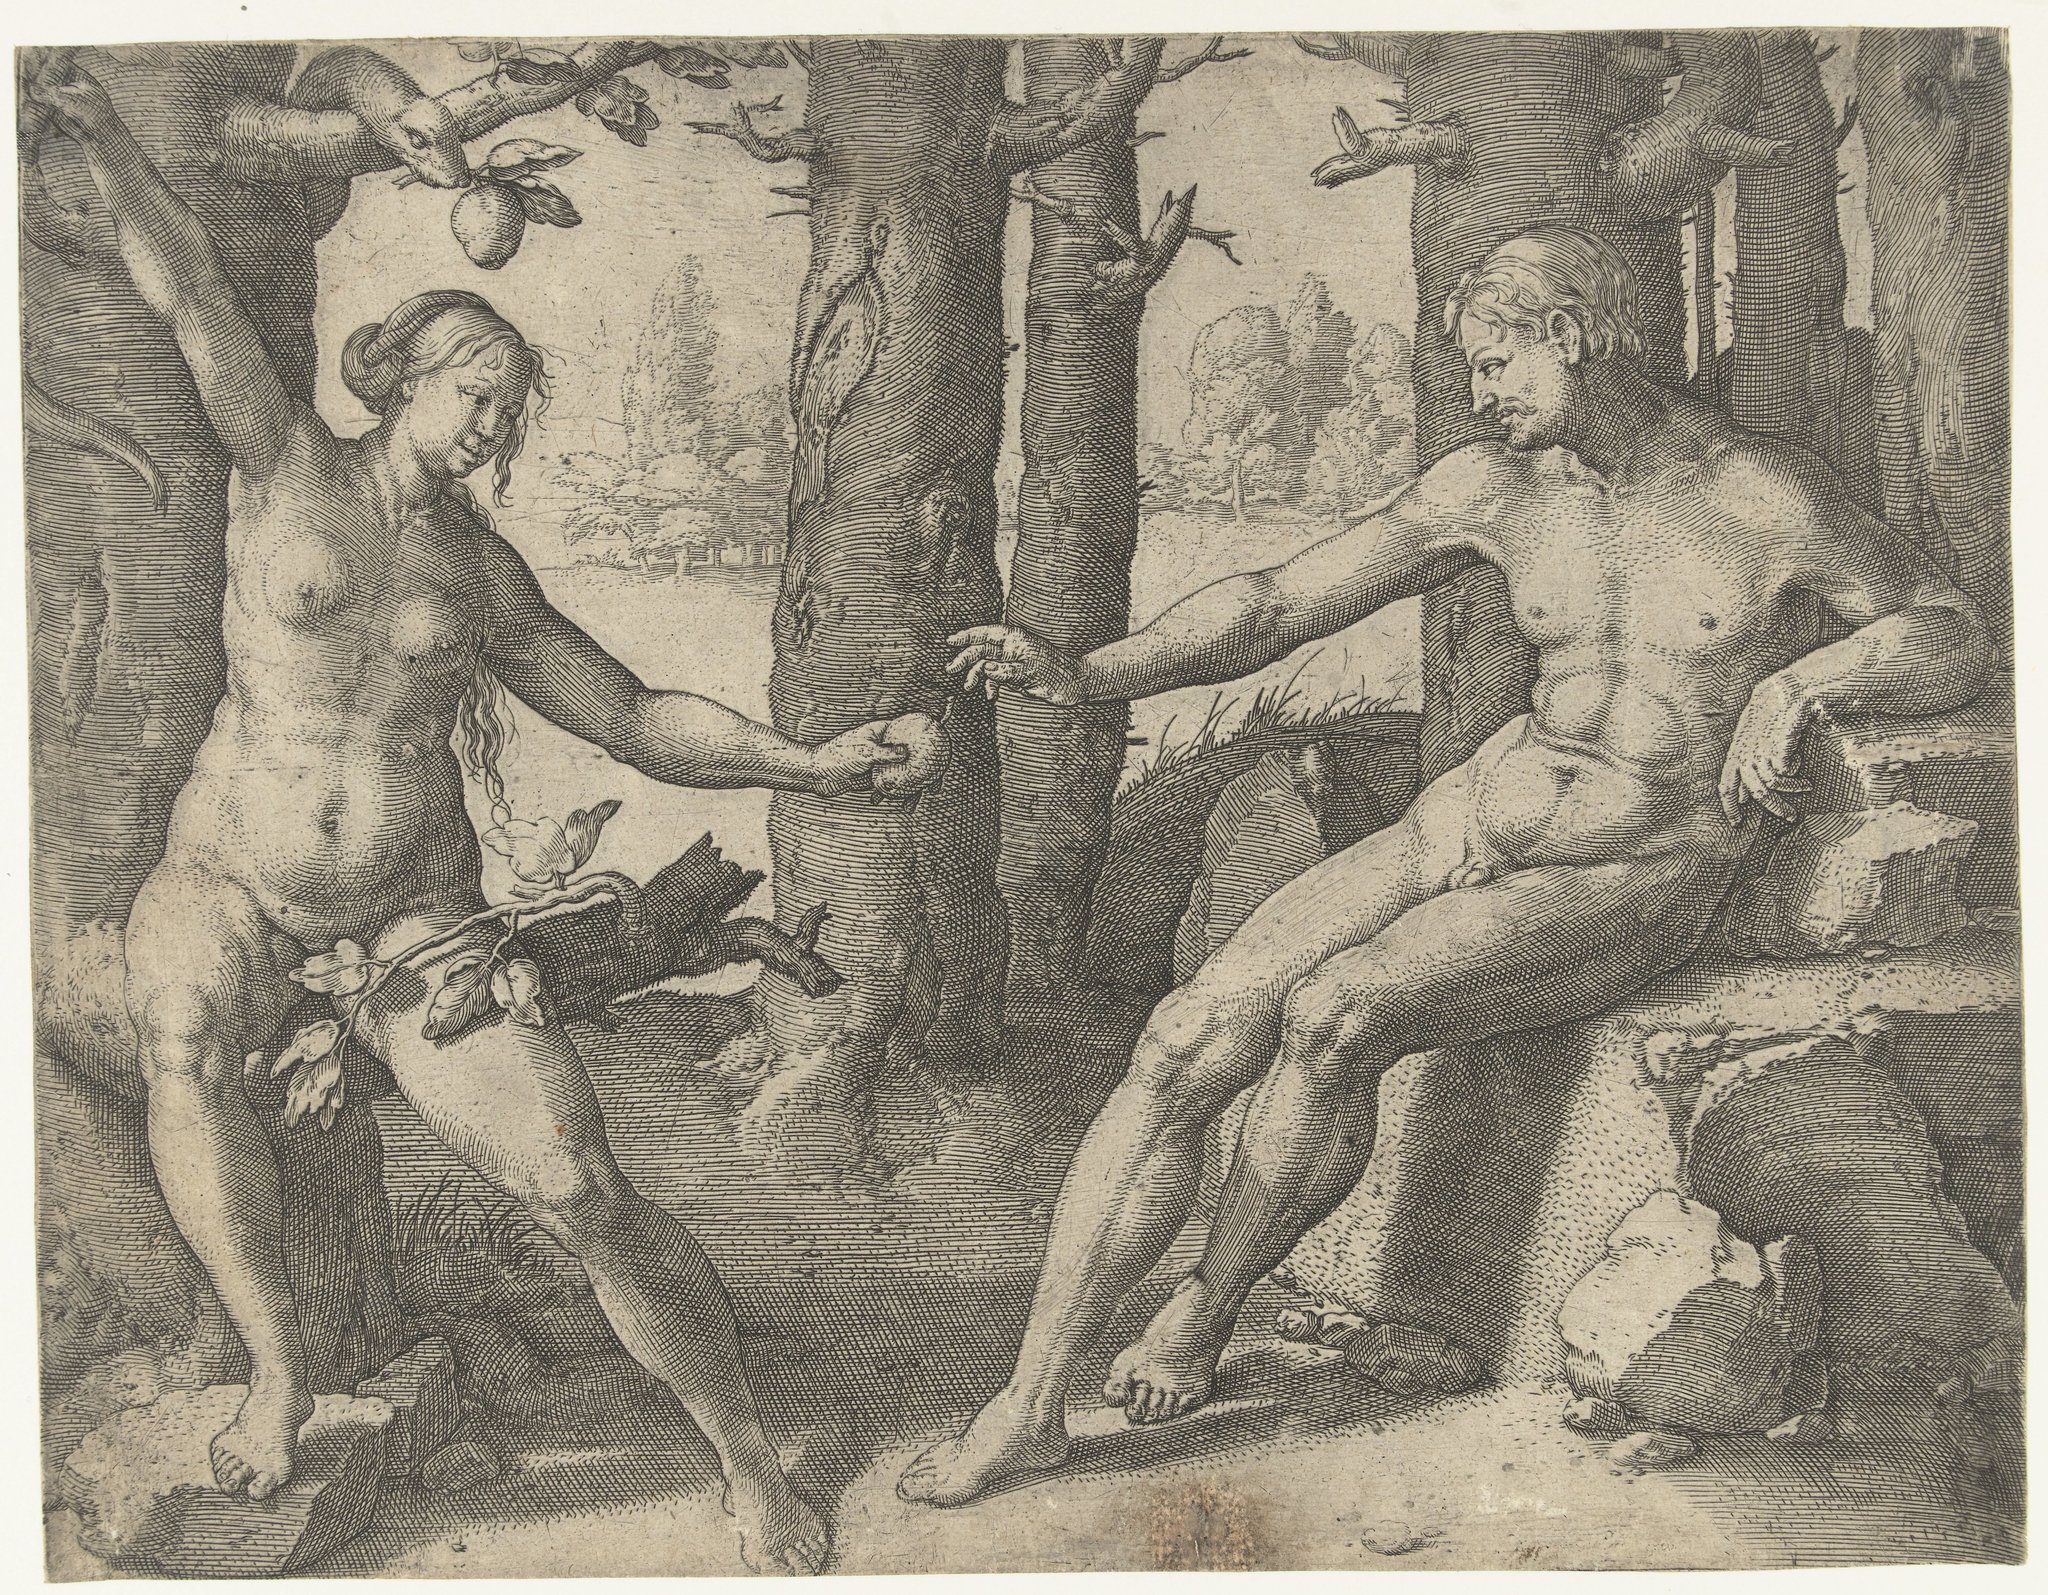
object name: print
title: De zondeval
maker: lucas van leyden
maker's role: draughtsman, painter, print maker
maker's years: 1494-1533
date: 1528-1532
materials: paper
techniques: engraving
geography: low countries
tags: eve offers the fruit to adam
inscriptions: collector's mark: Lugt 11